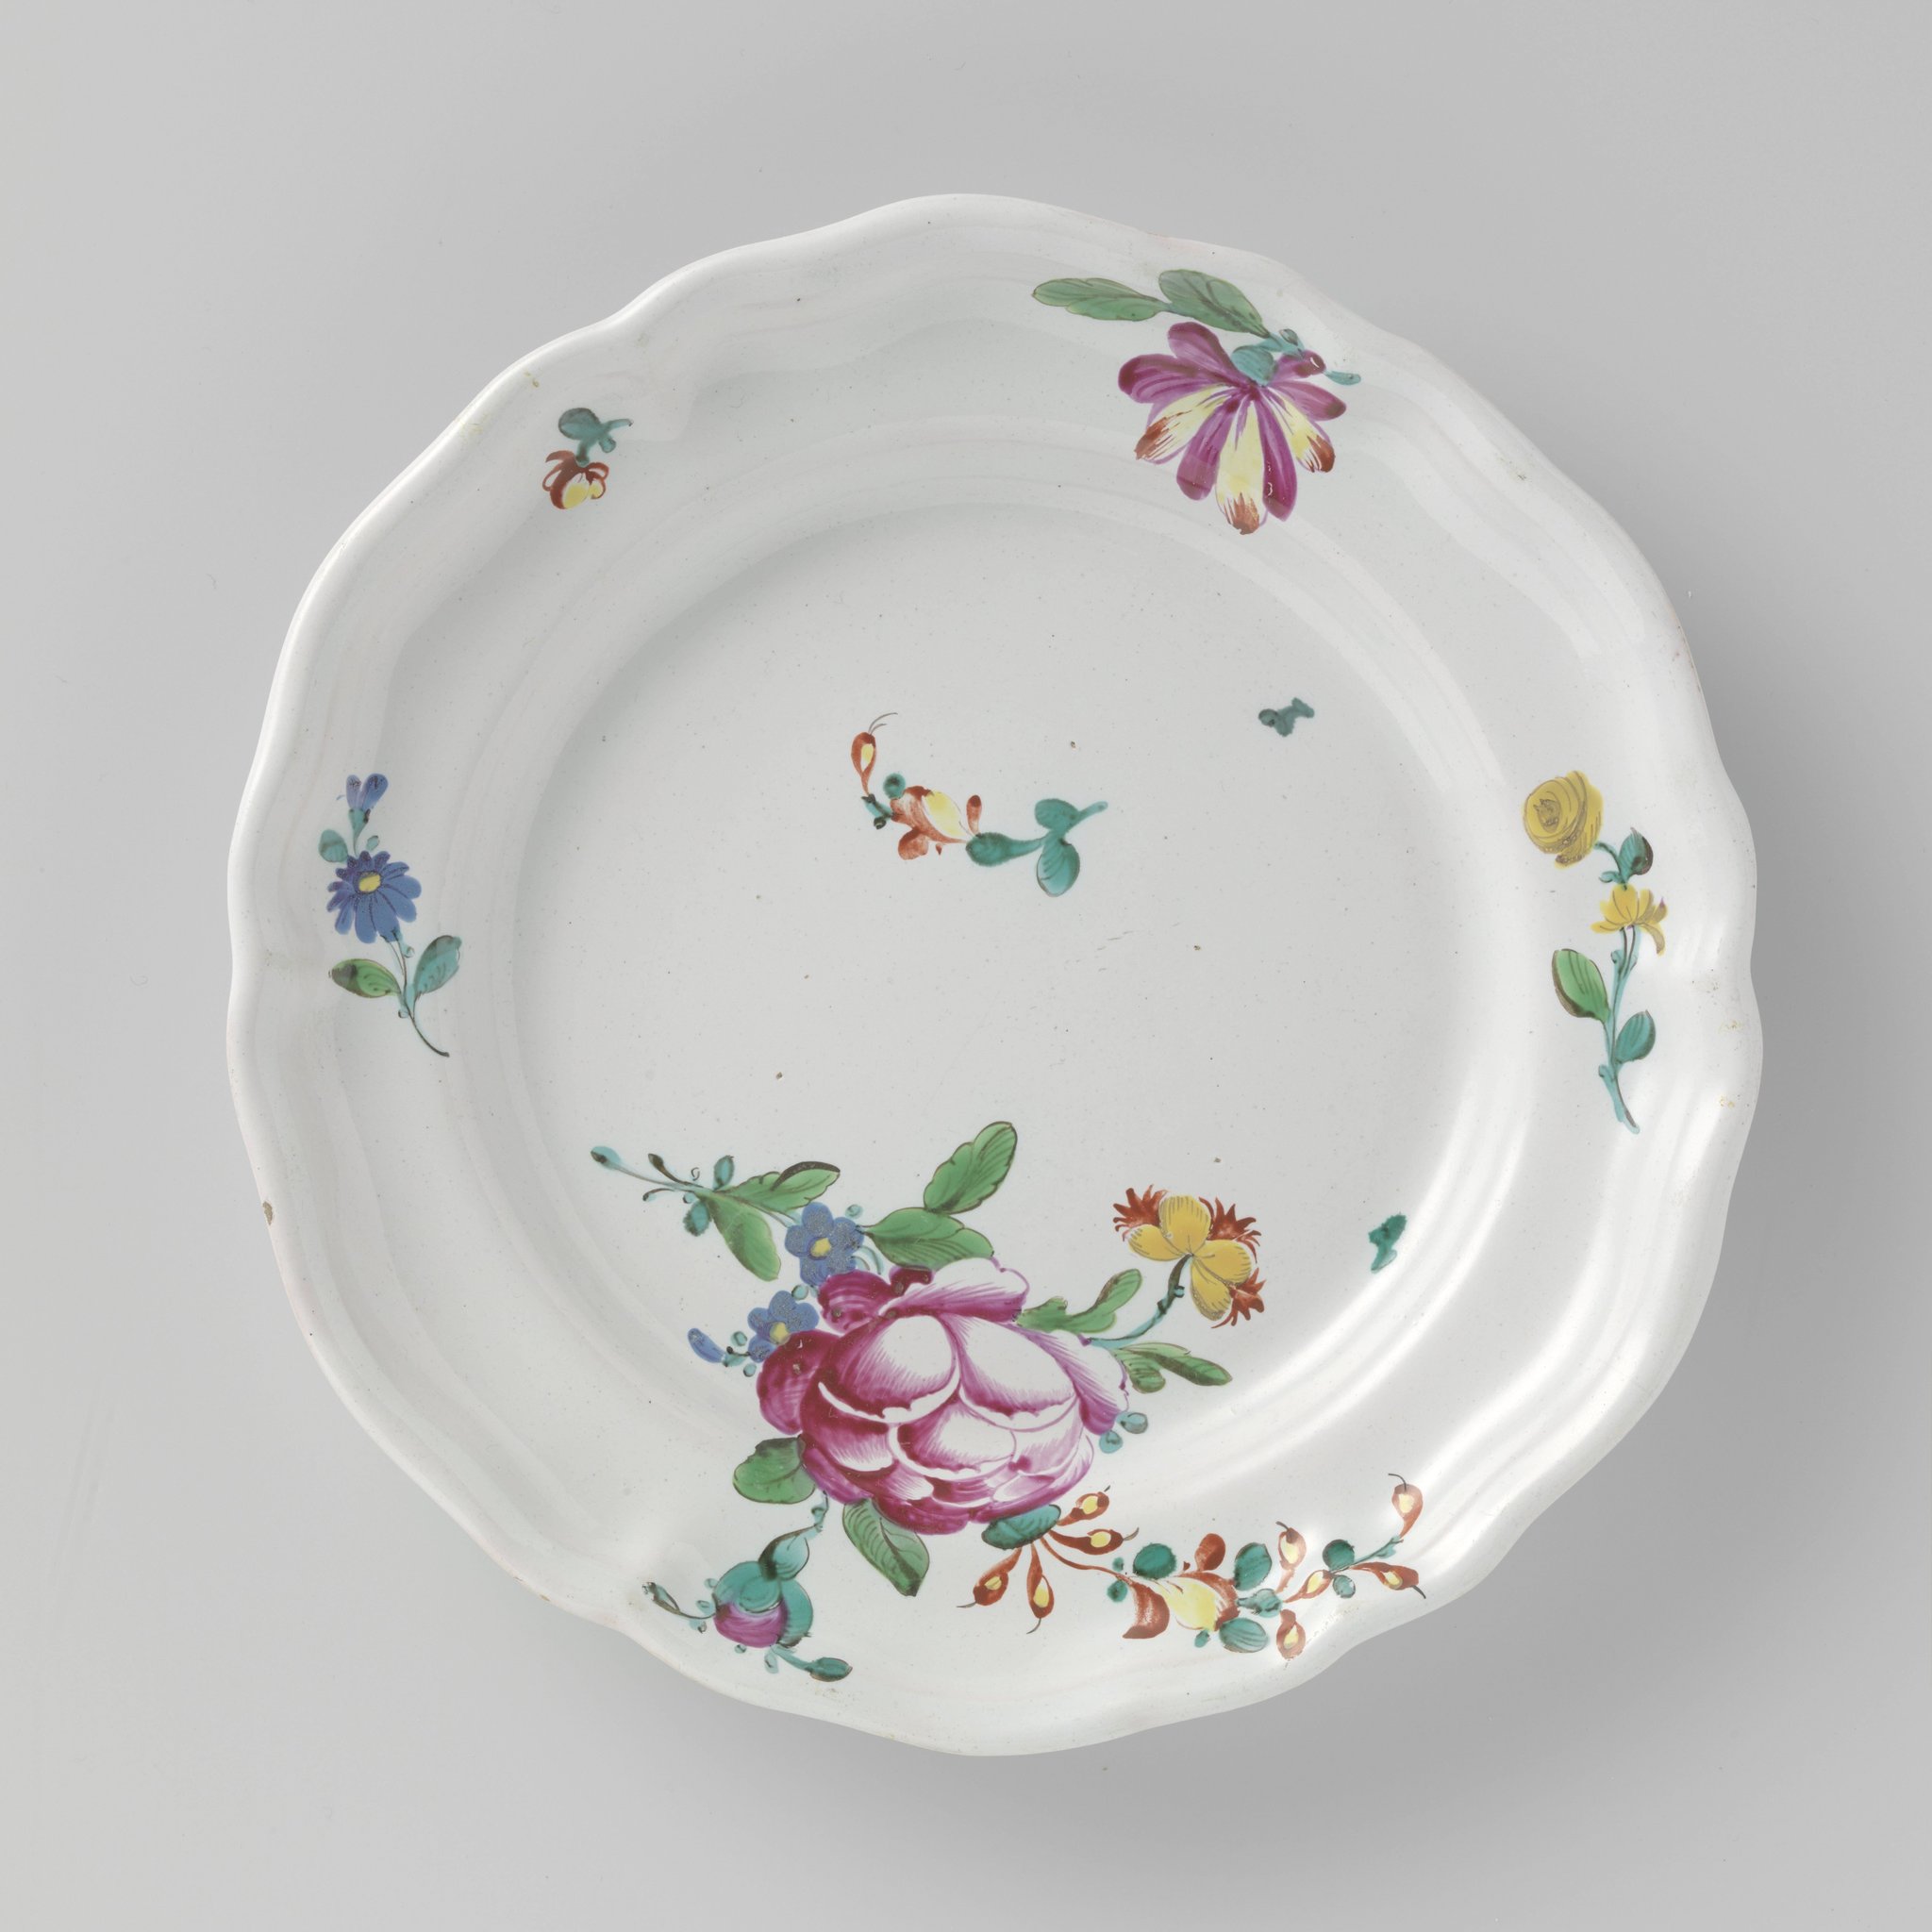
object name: plate dish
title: Bord, beschilderd met bloemboeket met grote roos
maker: Anonymous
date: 1760-1775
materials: faience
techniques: painted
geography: holitsch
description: Plate. Faience with petit feu decoration. Holitsch (Hungary), c. 1760 - 1775.